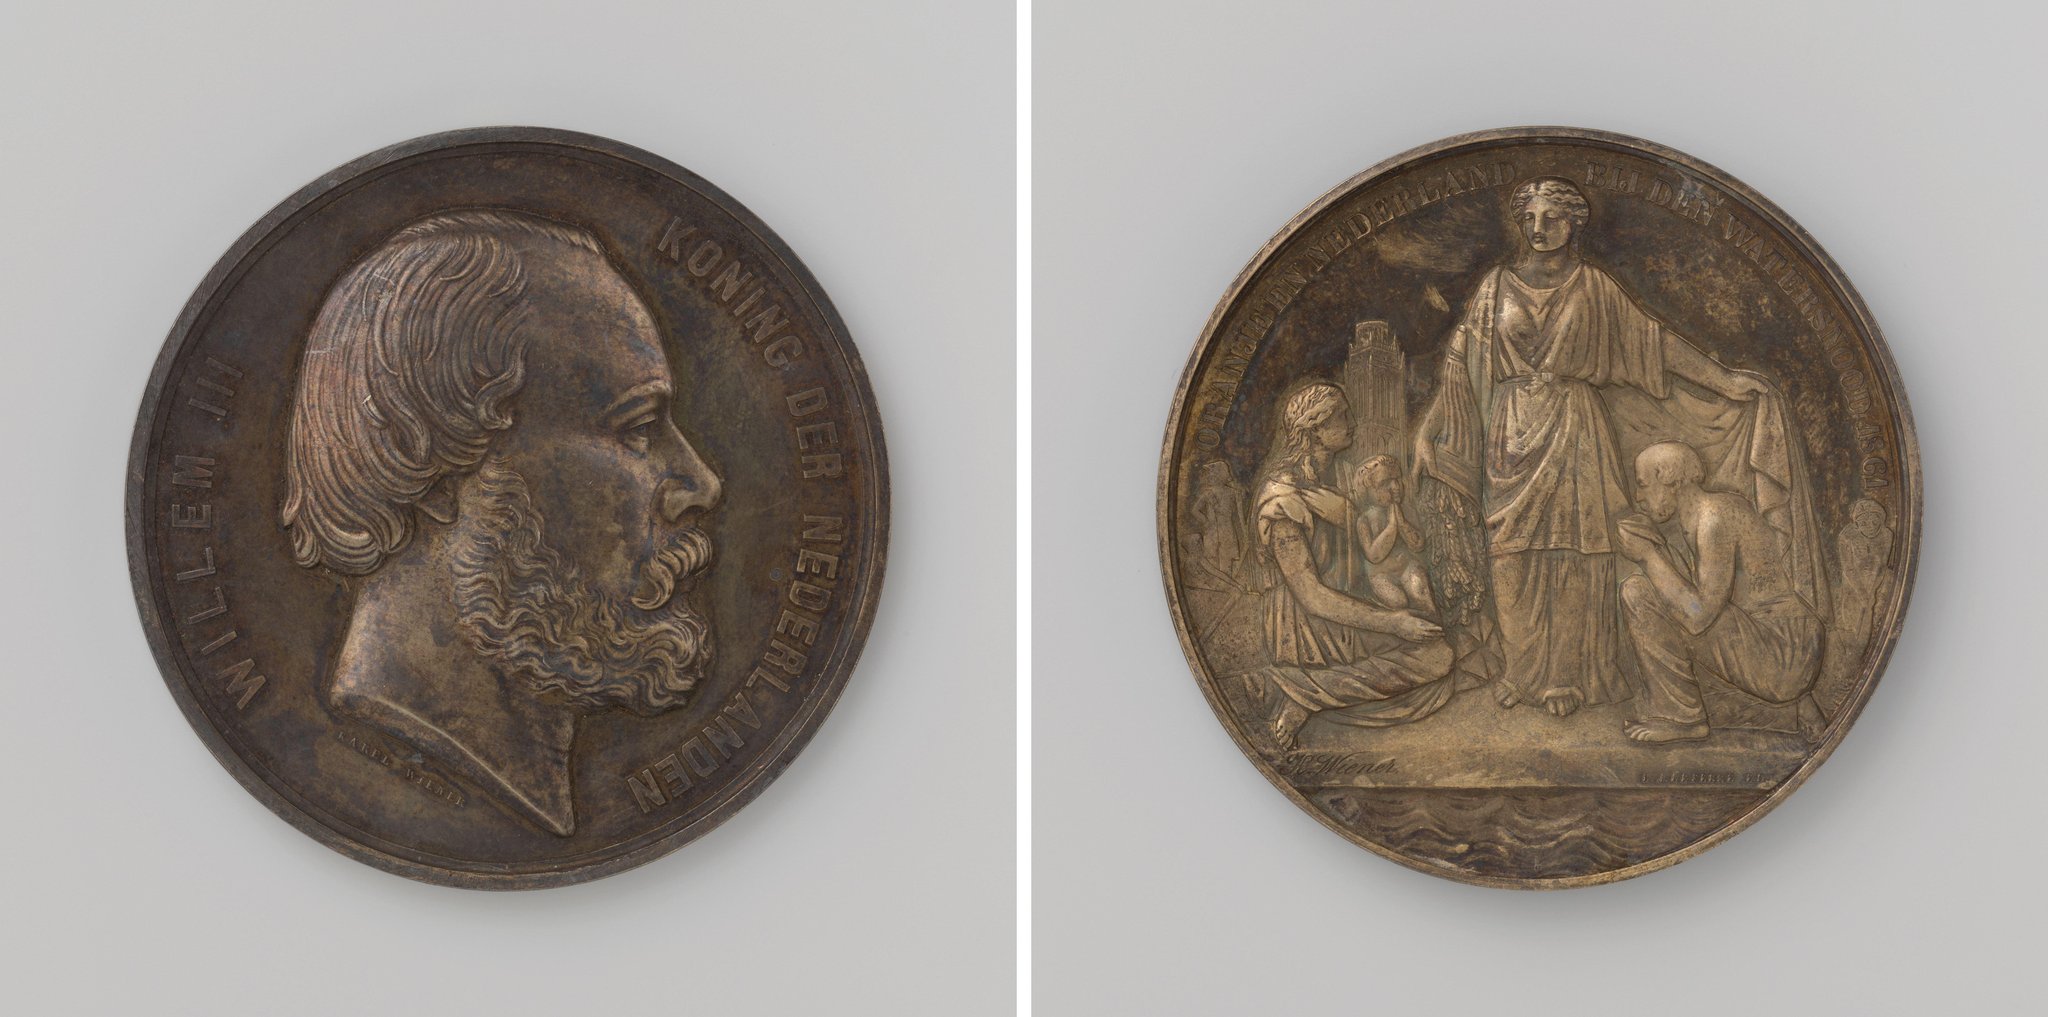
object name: honorary medal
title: Willem III, koning der Nederlanden, wegens zijn ondersteuning bij de watersnoodramp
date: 1861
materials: silver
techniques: gilding, striking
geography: the hague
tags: brussels, willem iii (koning der nederlanden)